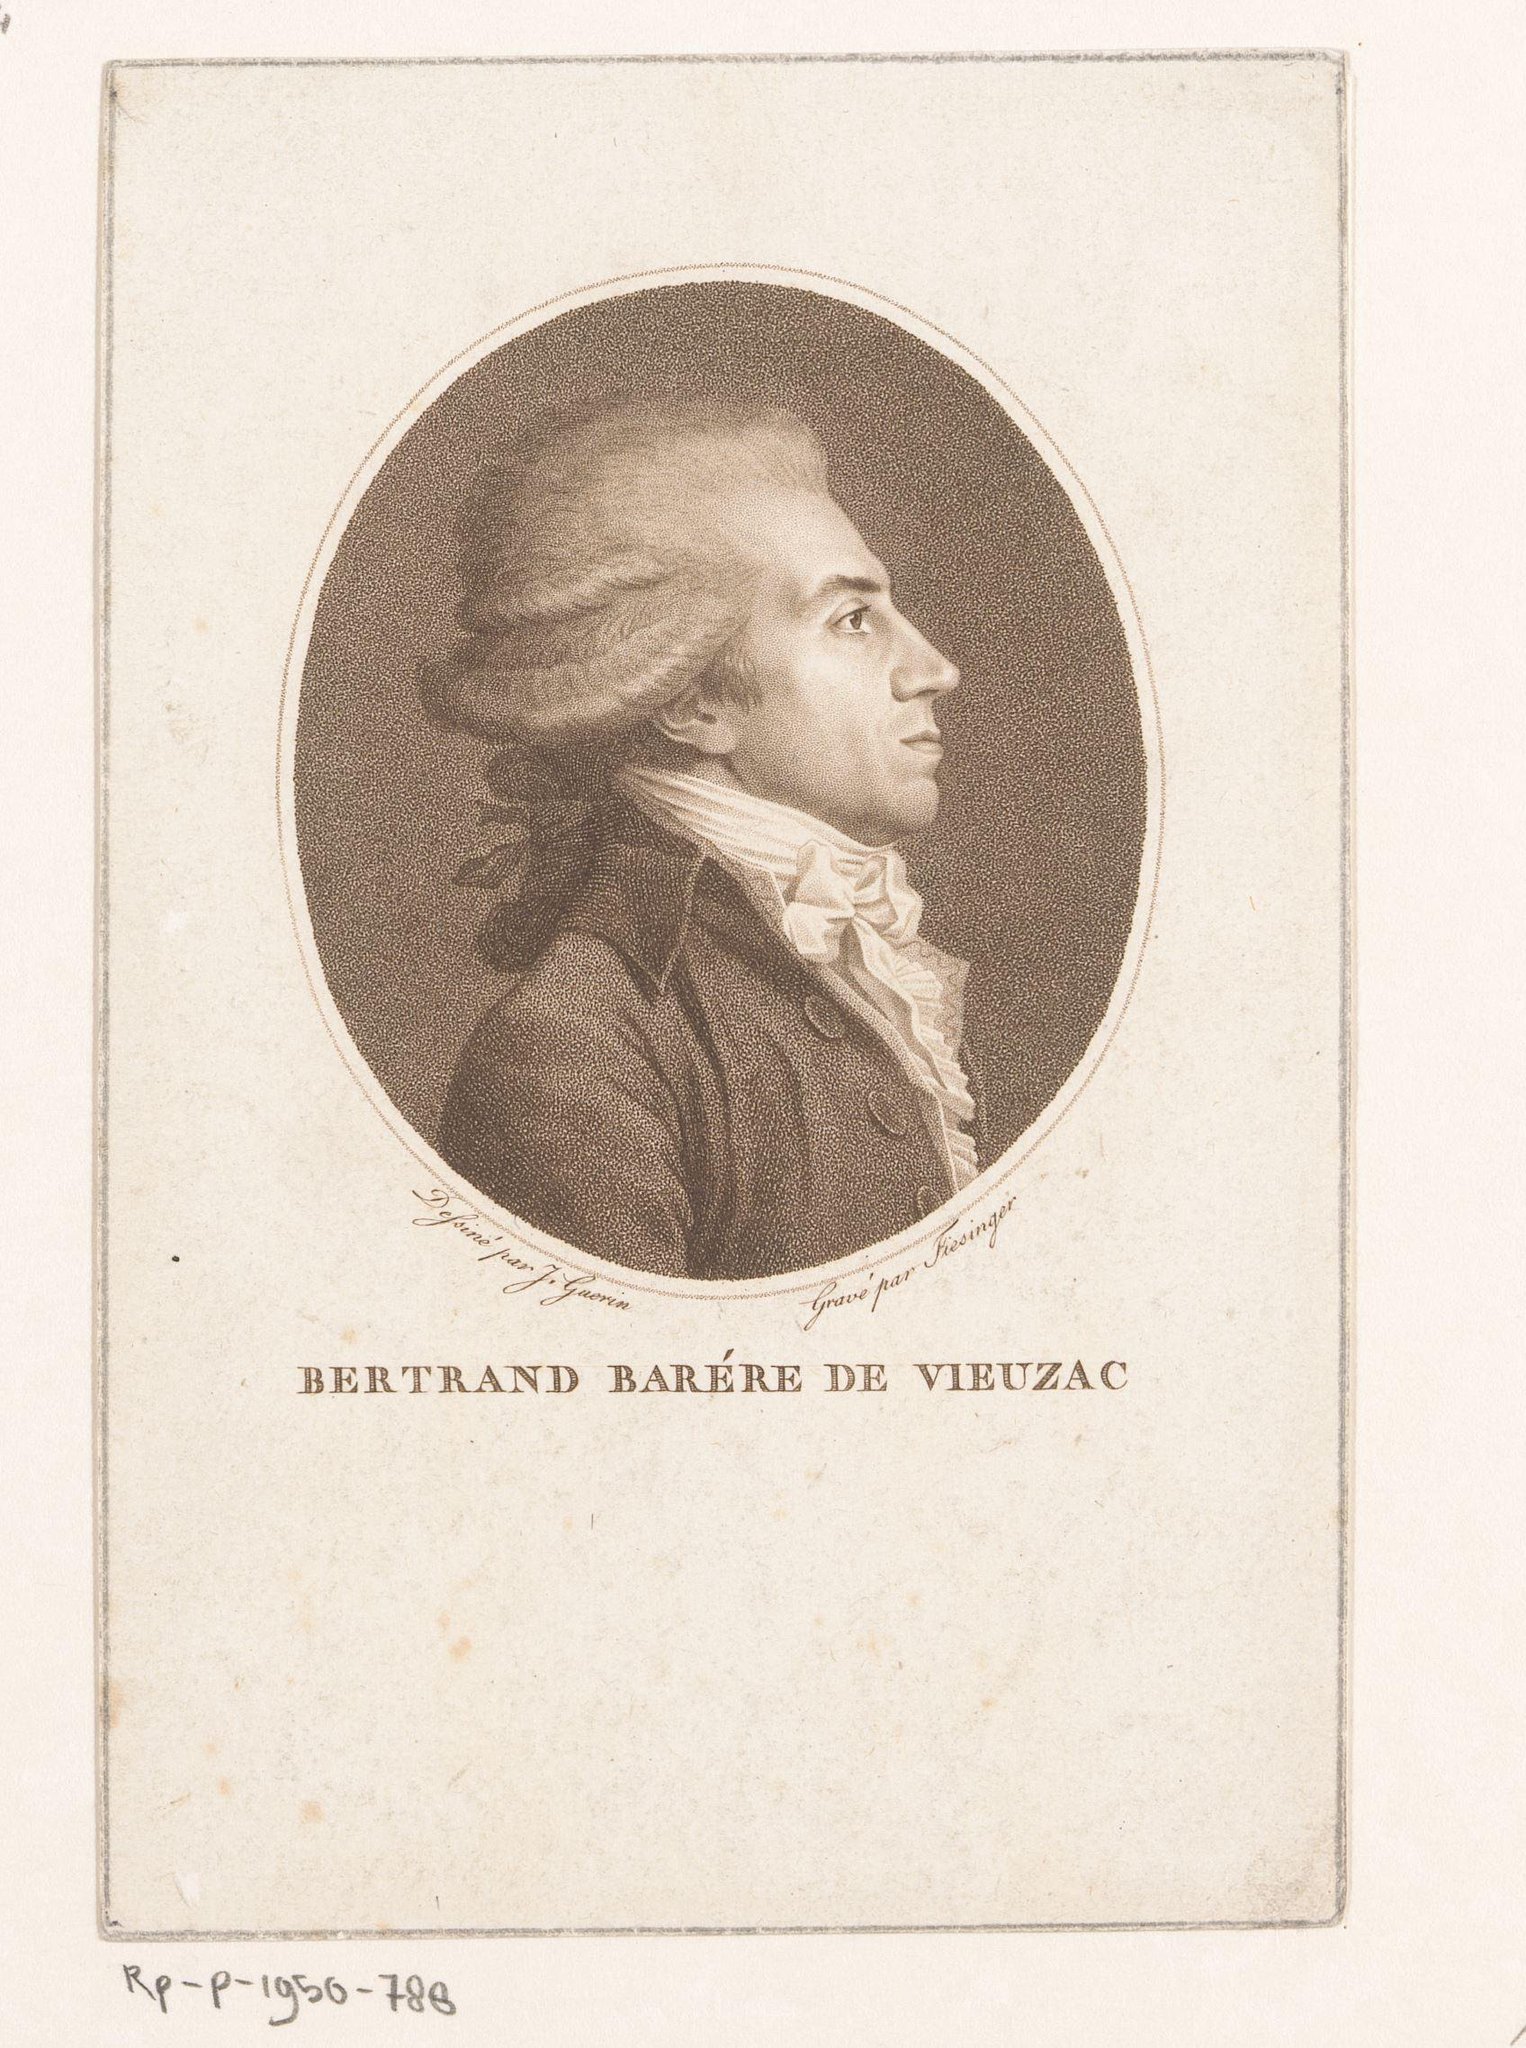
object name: print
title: Portret van Bertrand Barére de Vienzac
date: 1765-1807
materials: paper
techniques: stippling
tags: politician, historical persons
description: Prent uit een serie portretten van Franse revolutionairen.